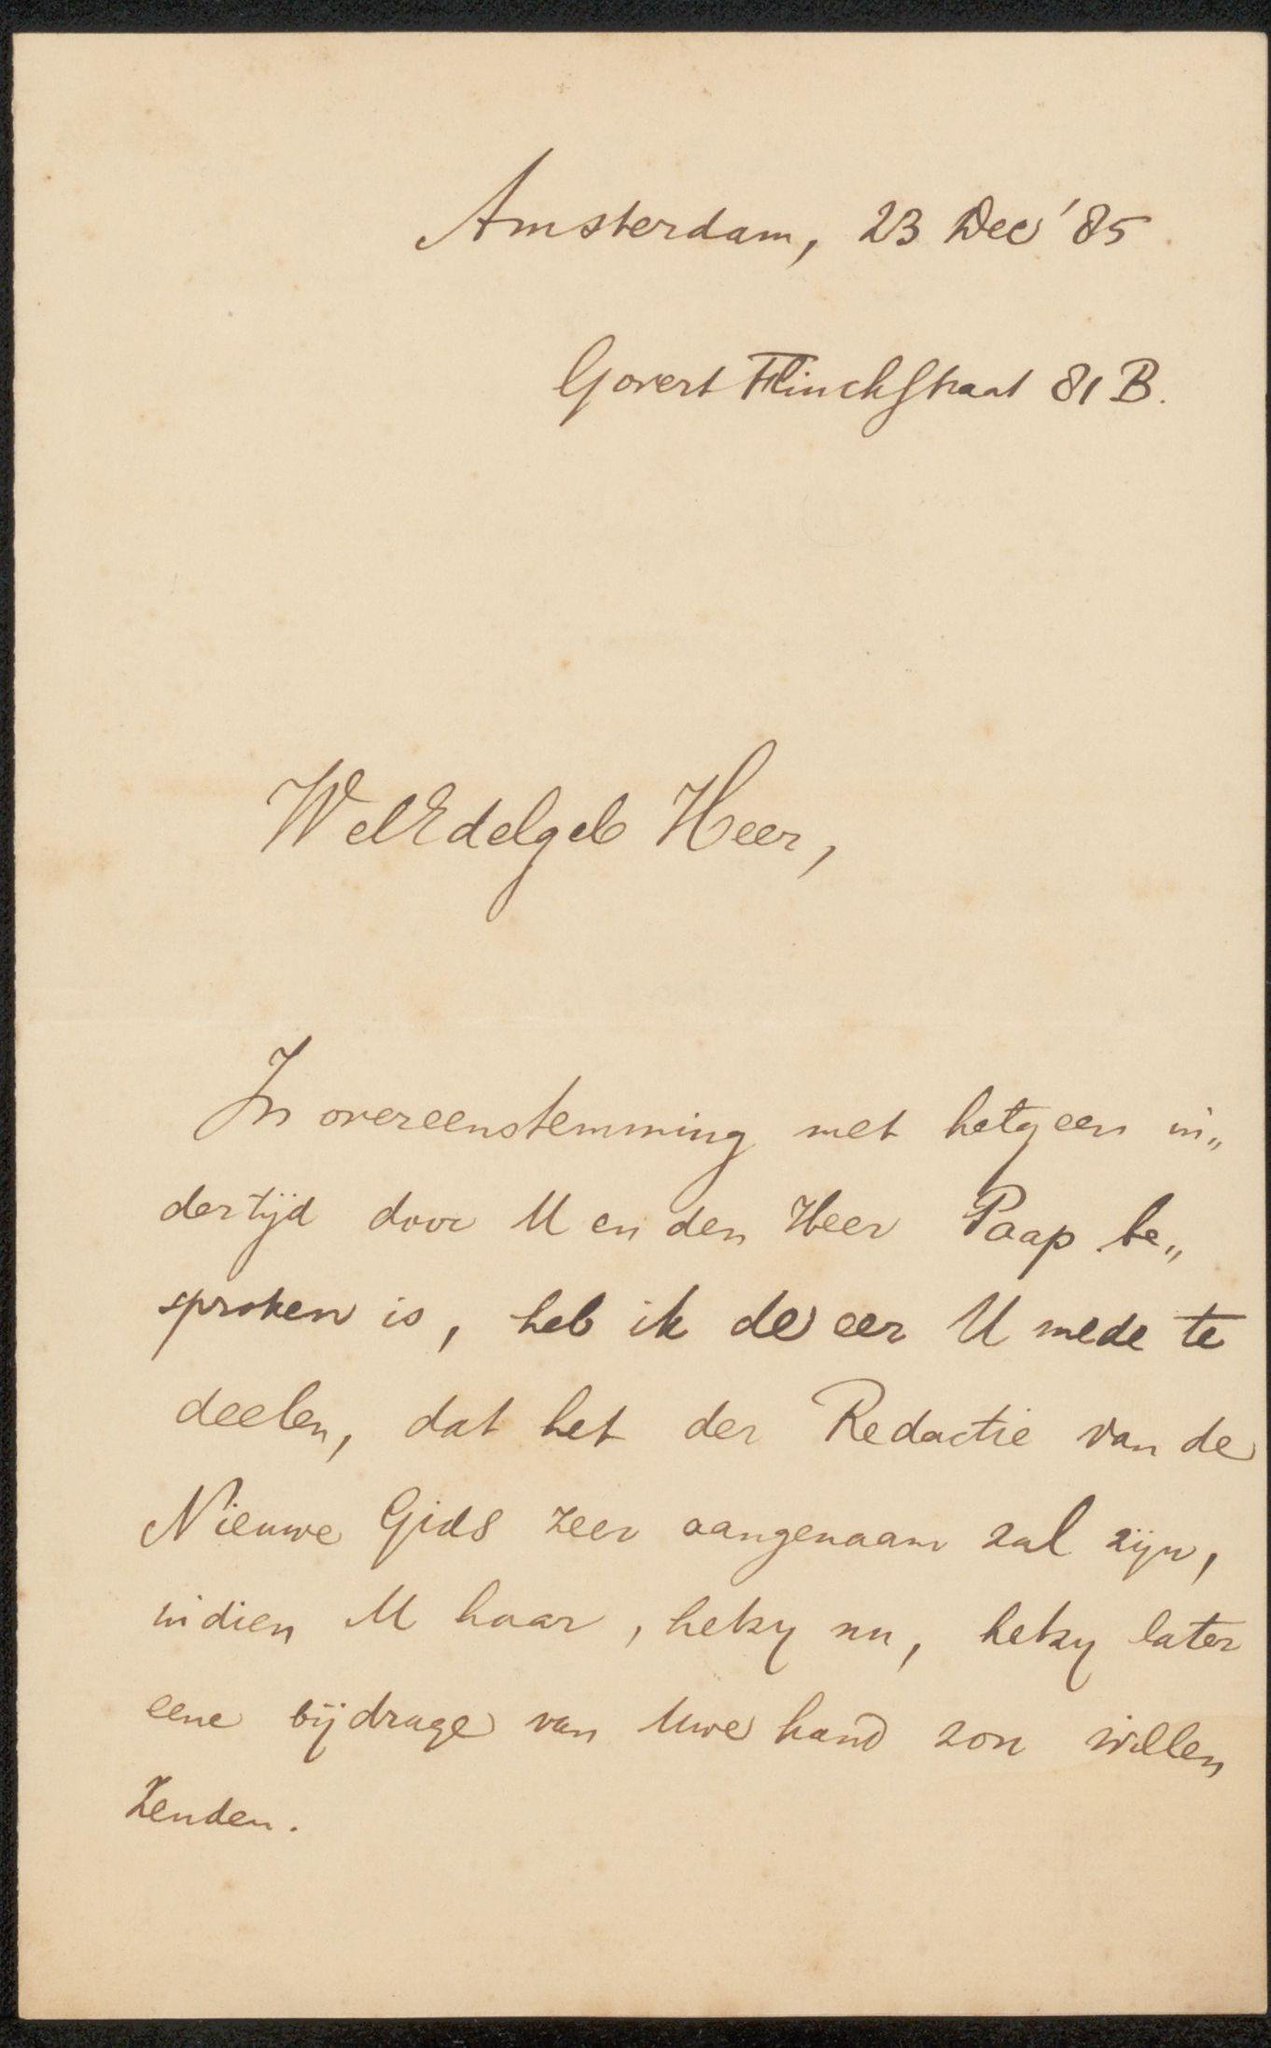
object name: letter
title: Brief aan Philip Zilcken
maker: willem kloos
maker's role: dichter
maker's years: 1859-1938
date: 1885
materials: ink, paper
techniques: pen, writing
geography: amsterdam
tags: zeist, the hague, painter, draughtsman, philip zilcken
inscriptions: collector's mark: ‘RPK’